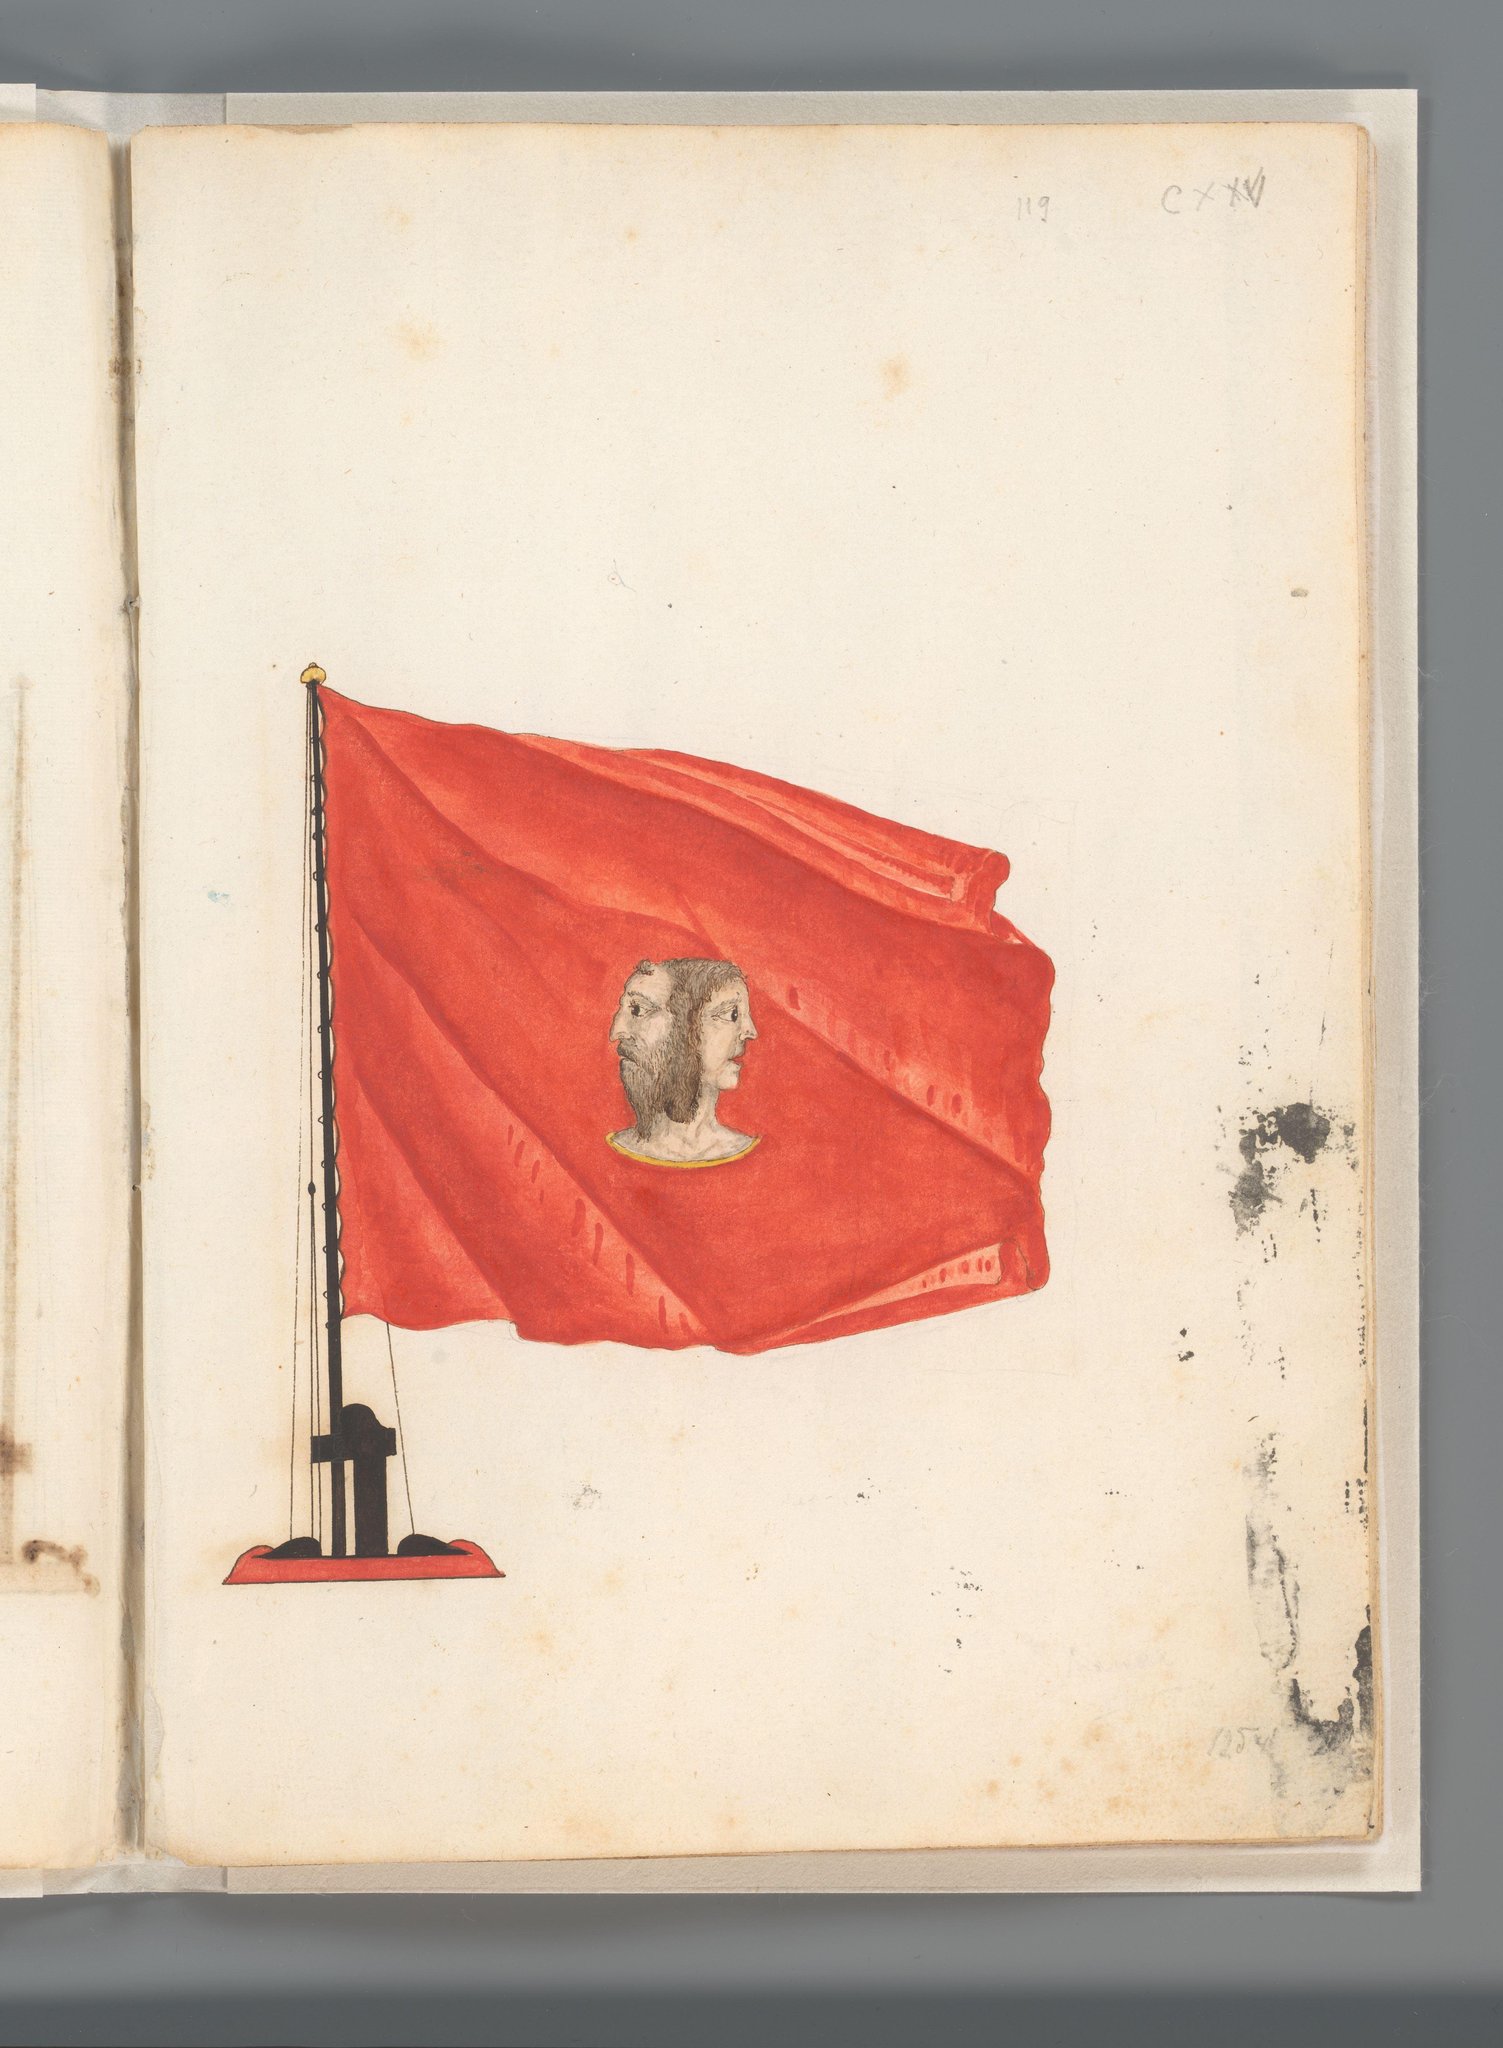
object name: drawing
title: Vlag van Rusland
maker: Anonymous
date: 1667-1670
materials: ink, paper, watercolor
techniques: brush, pen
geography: france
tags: flag, colours (as symbol of the state, etc.), russia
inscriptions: number: ‘119 / CXXV / 125’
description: Vlag van Rusland. Rode vlag met een januskop. Vlag op vlaggensteng en mastvoet. Afgebeeld op folio 63r. Onderdeel van een vlaggenboek met vlaggen uit Europa, Noord-Afrika, Nabije en Verre Oosten.